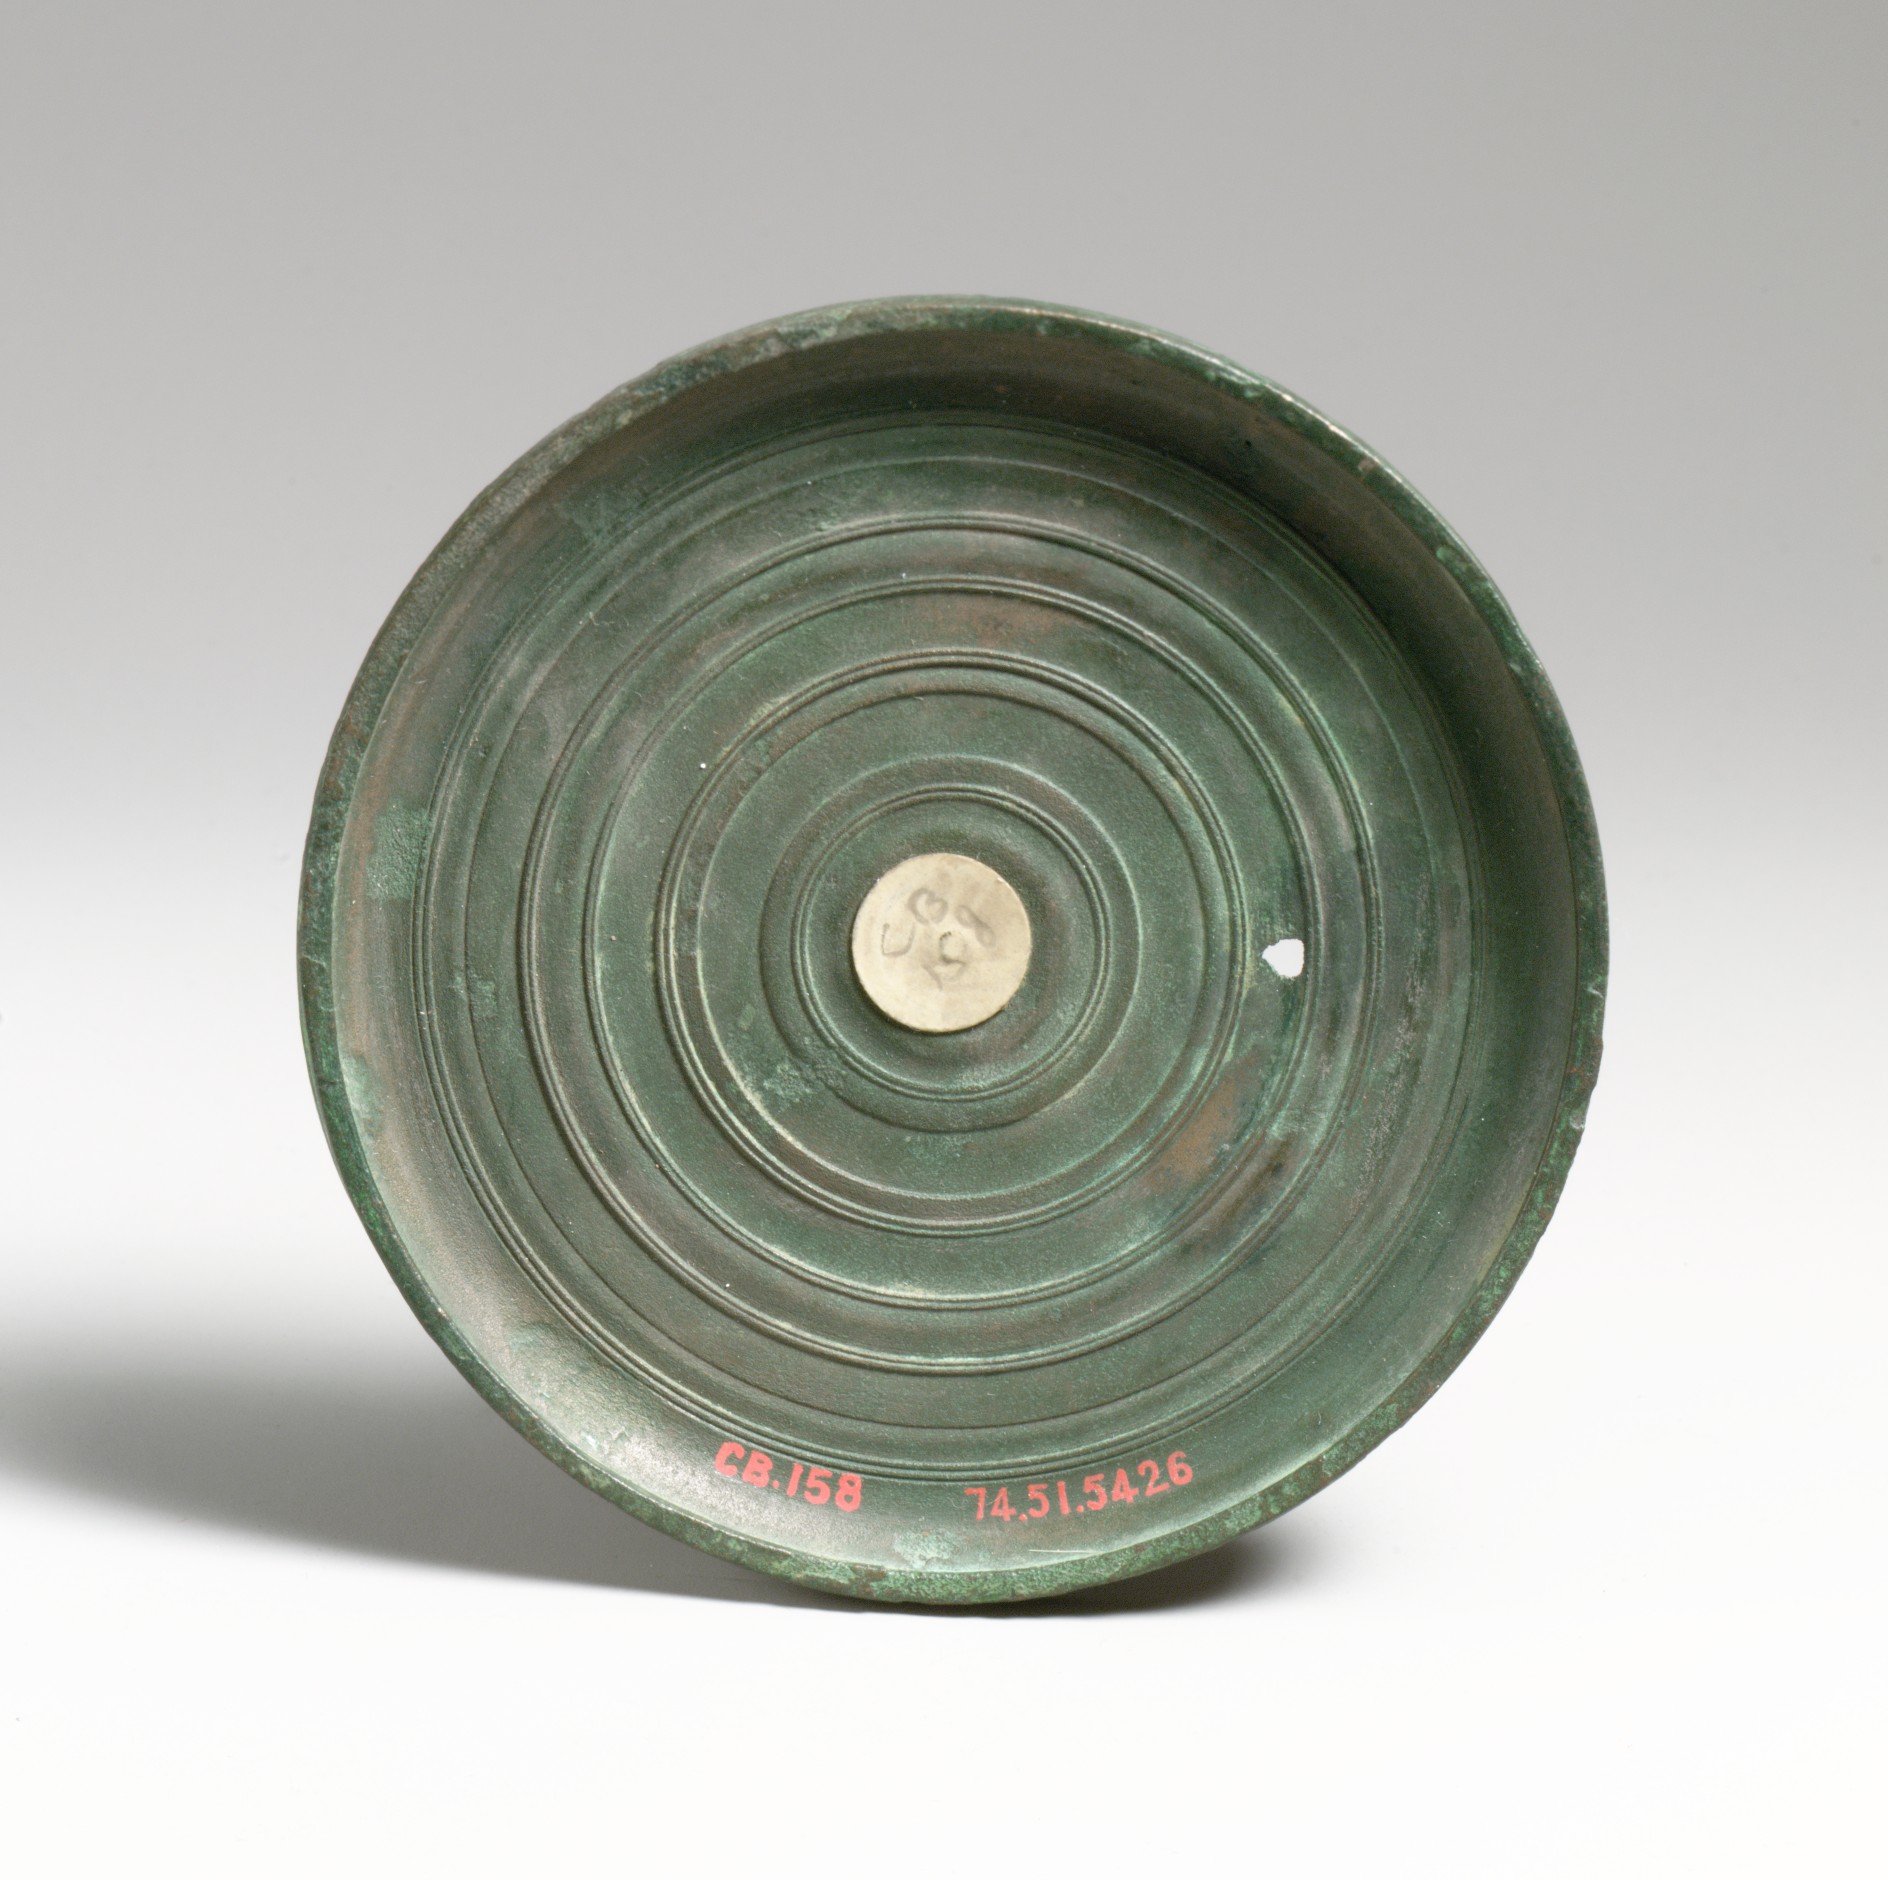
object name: mirror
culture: greek, cypriot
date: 7000-30 BCE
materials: bronze